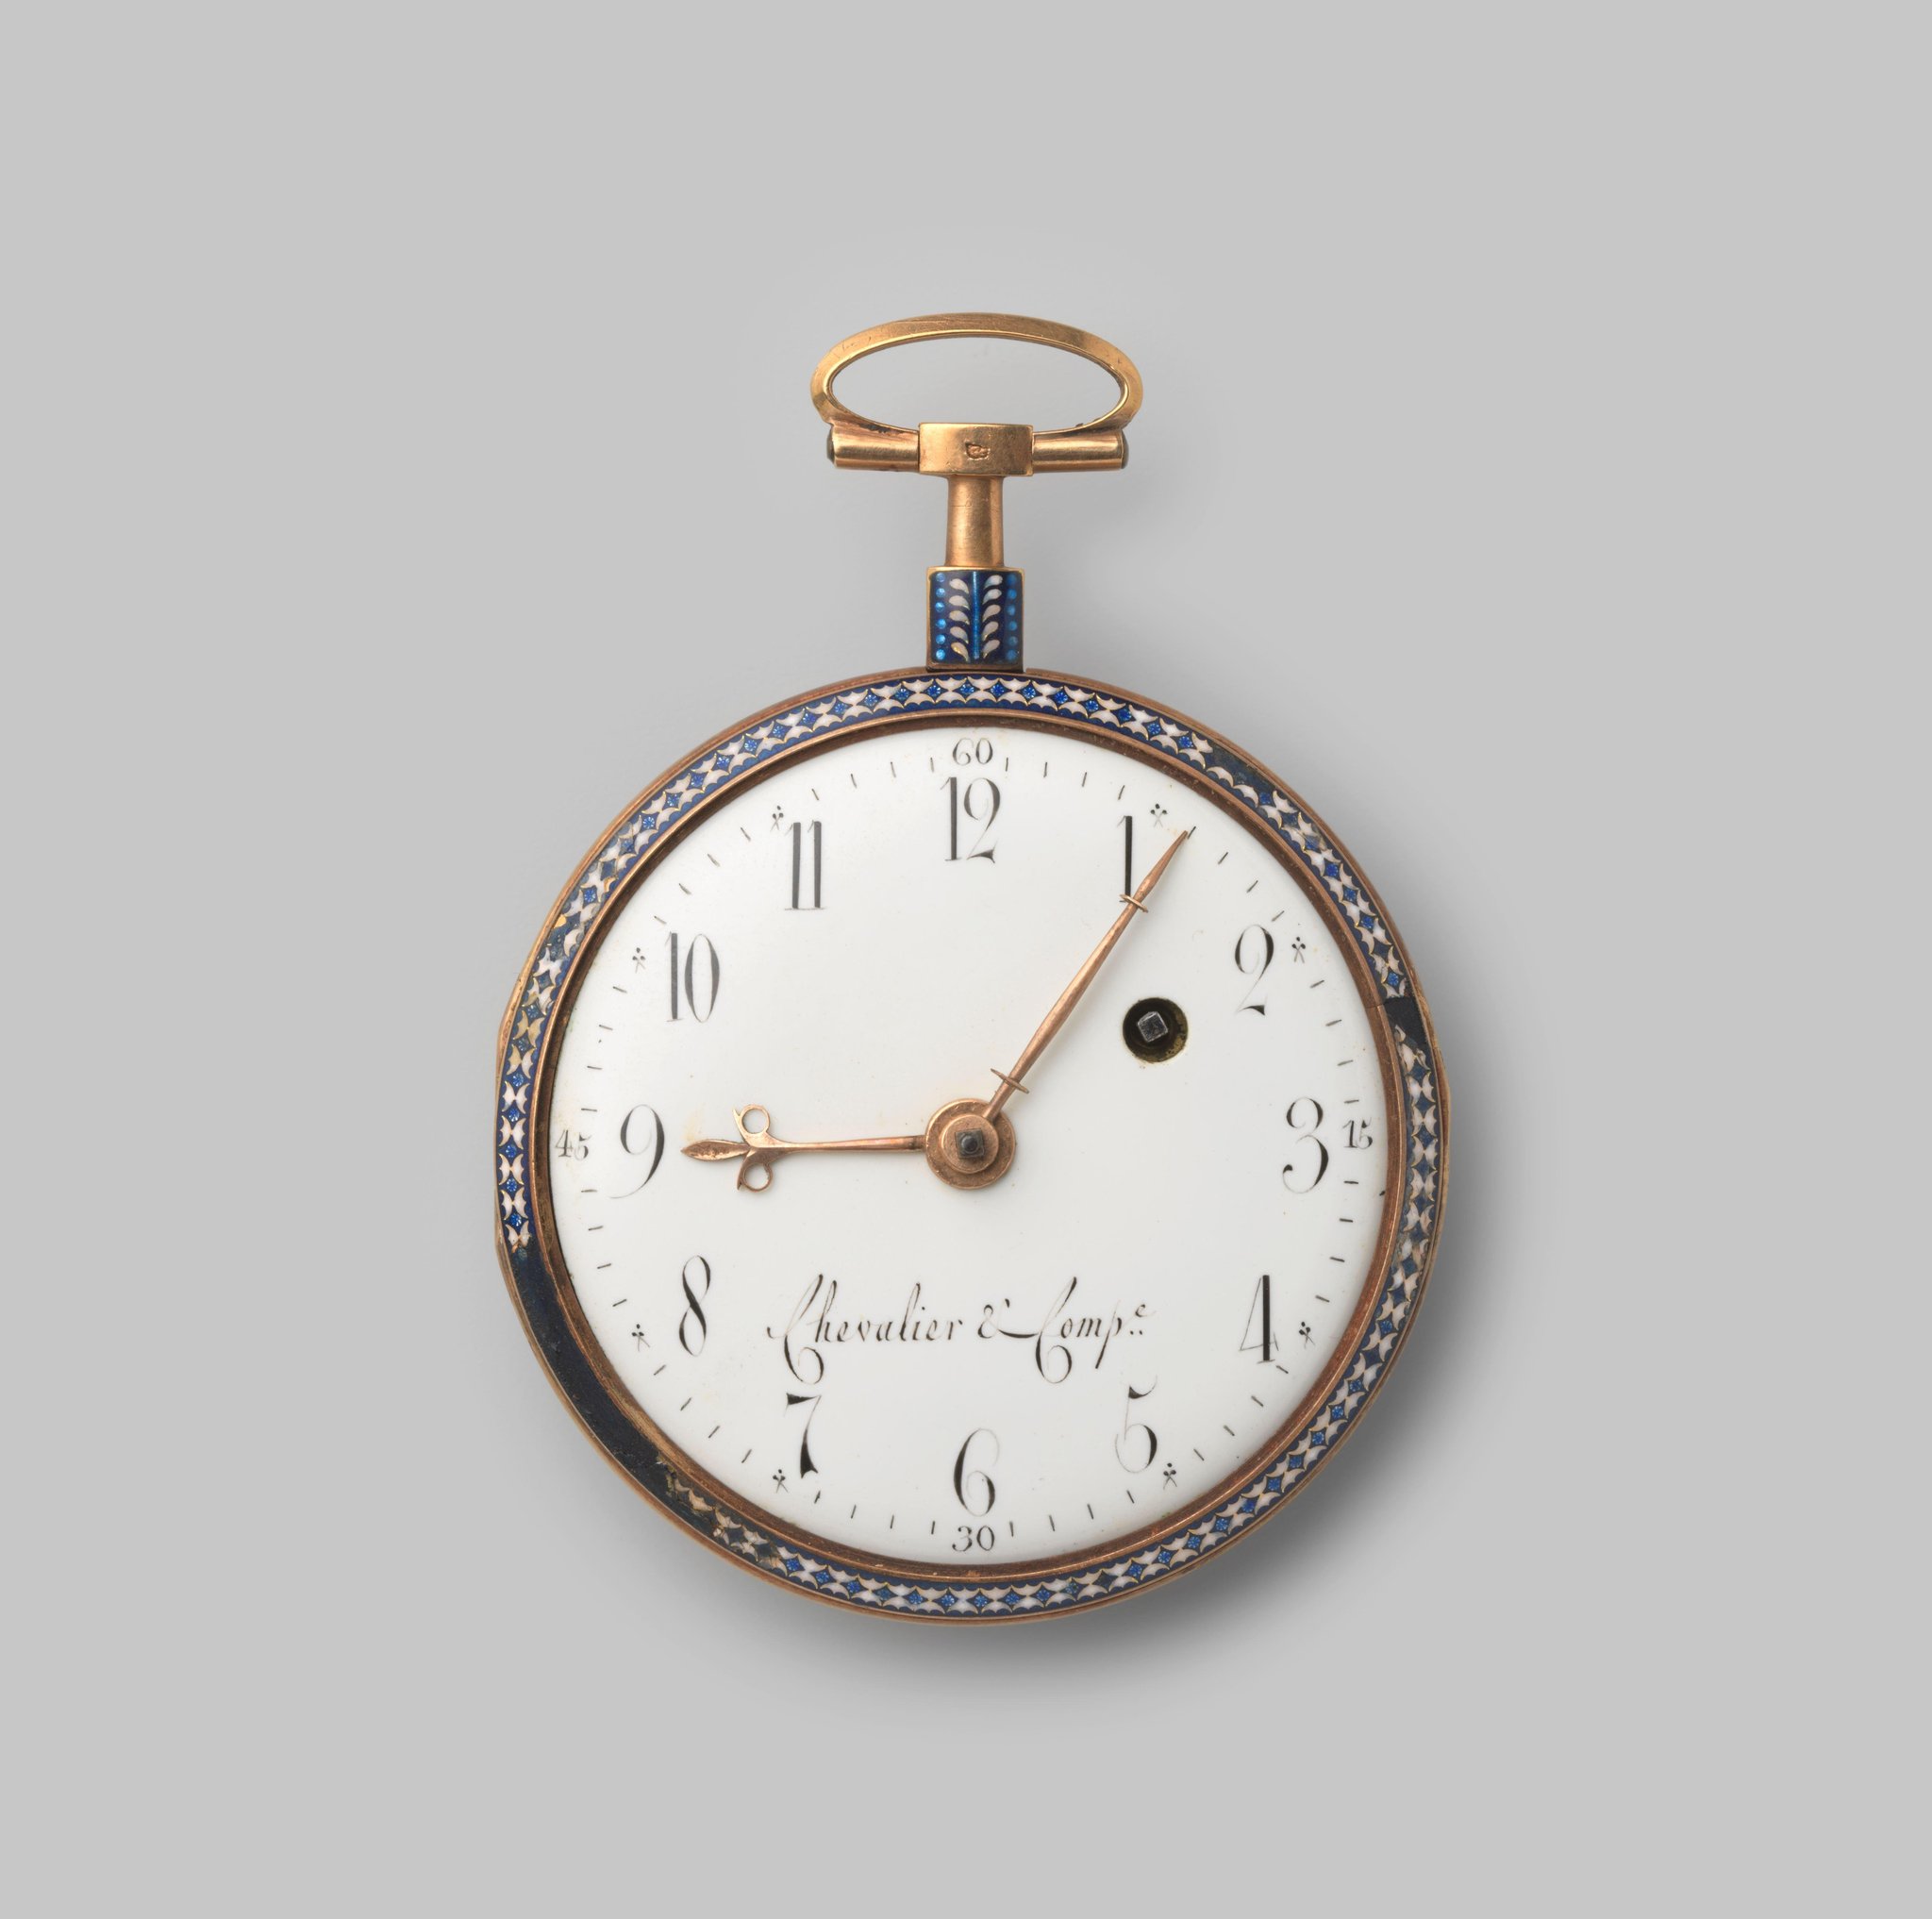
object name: jewellery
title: Horloge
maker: Anonymous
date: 1790-1830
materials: gold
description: Gouden heren zakhorloge. Op de achterbodem een emailversiering van een vrouw met jongentje in een bosrijk landschap.